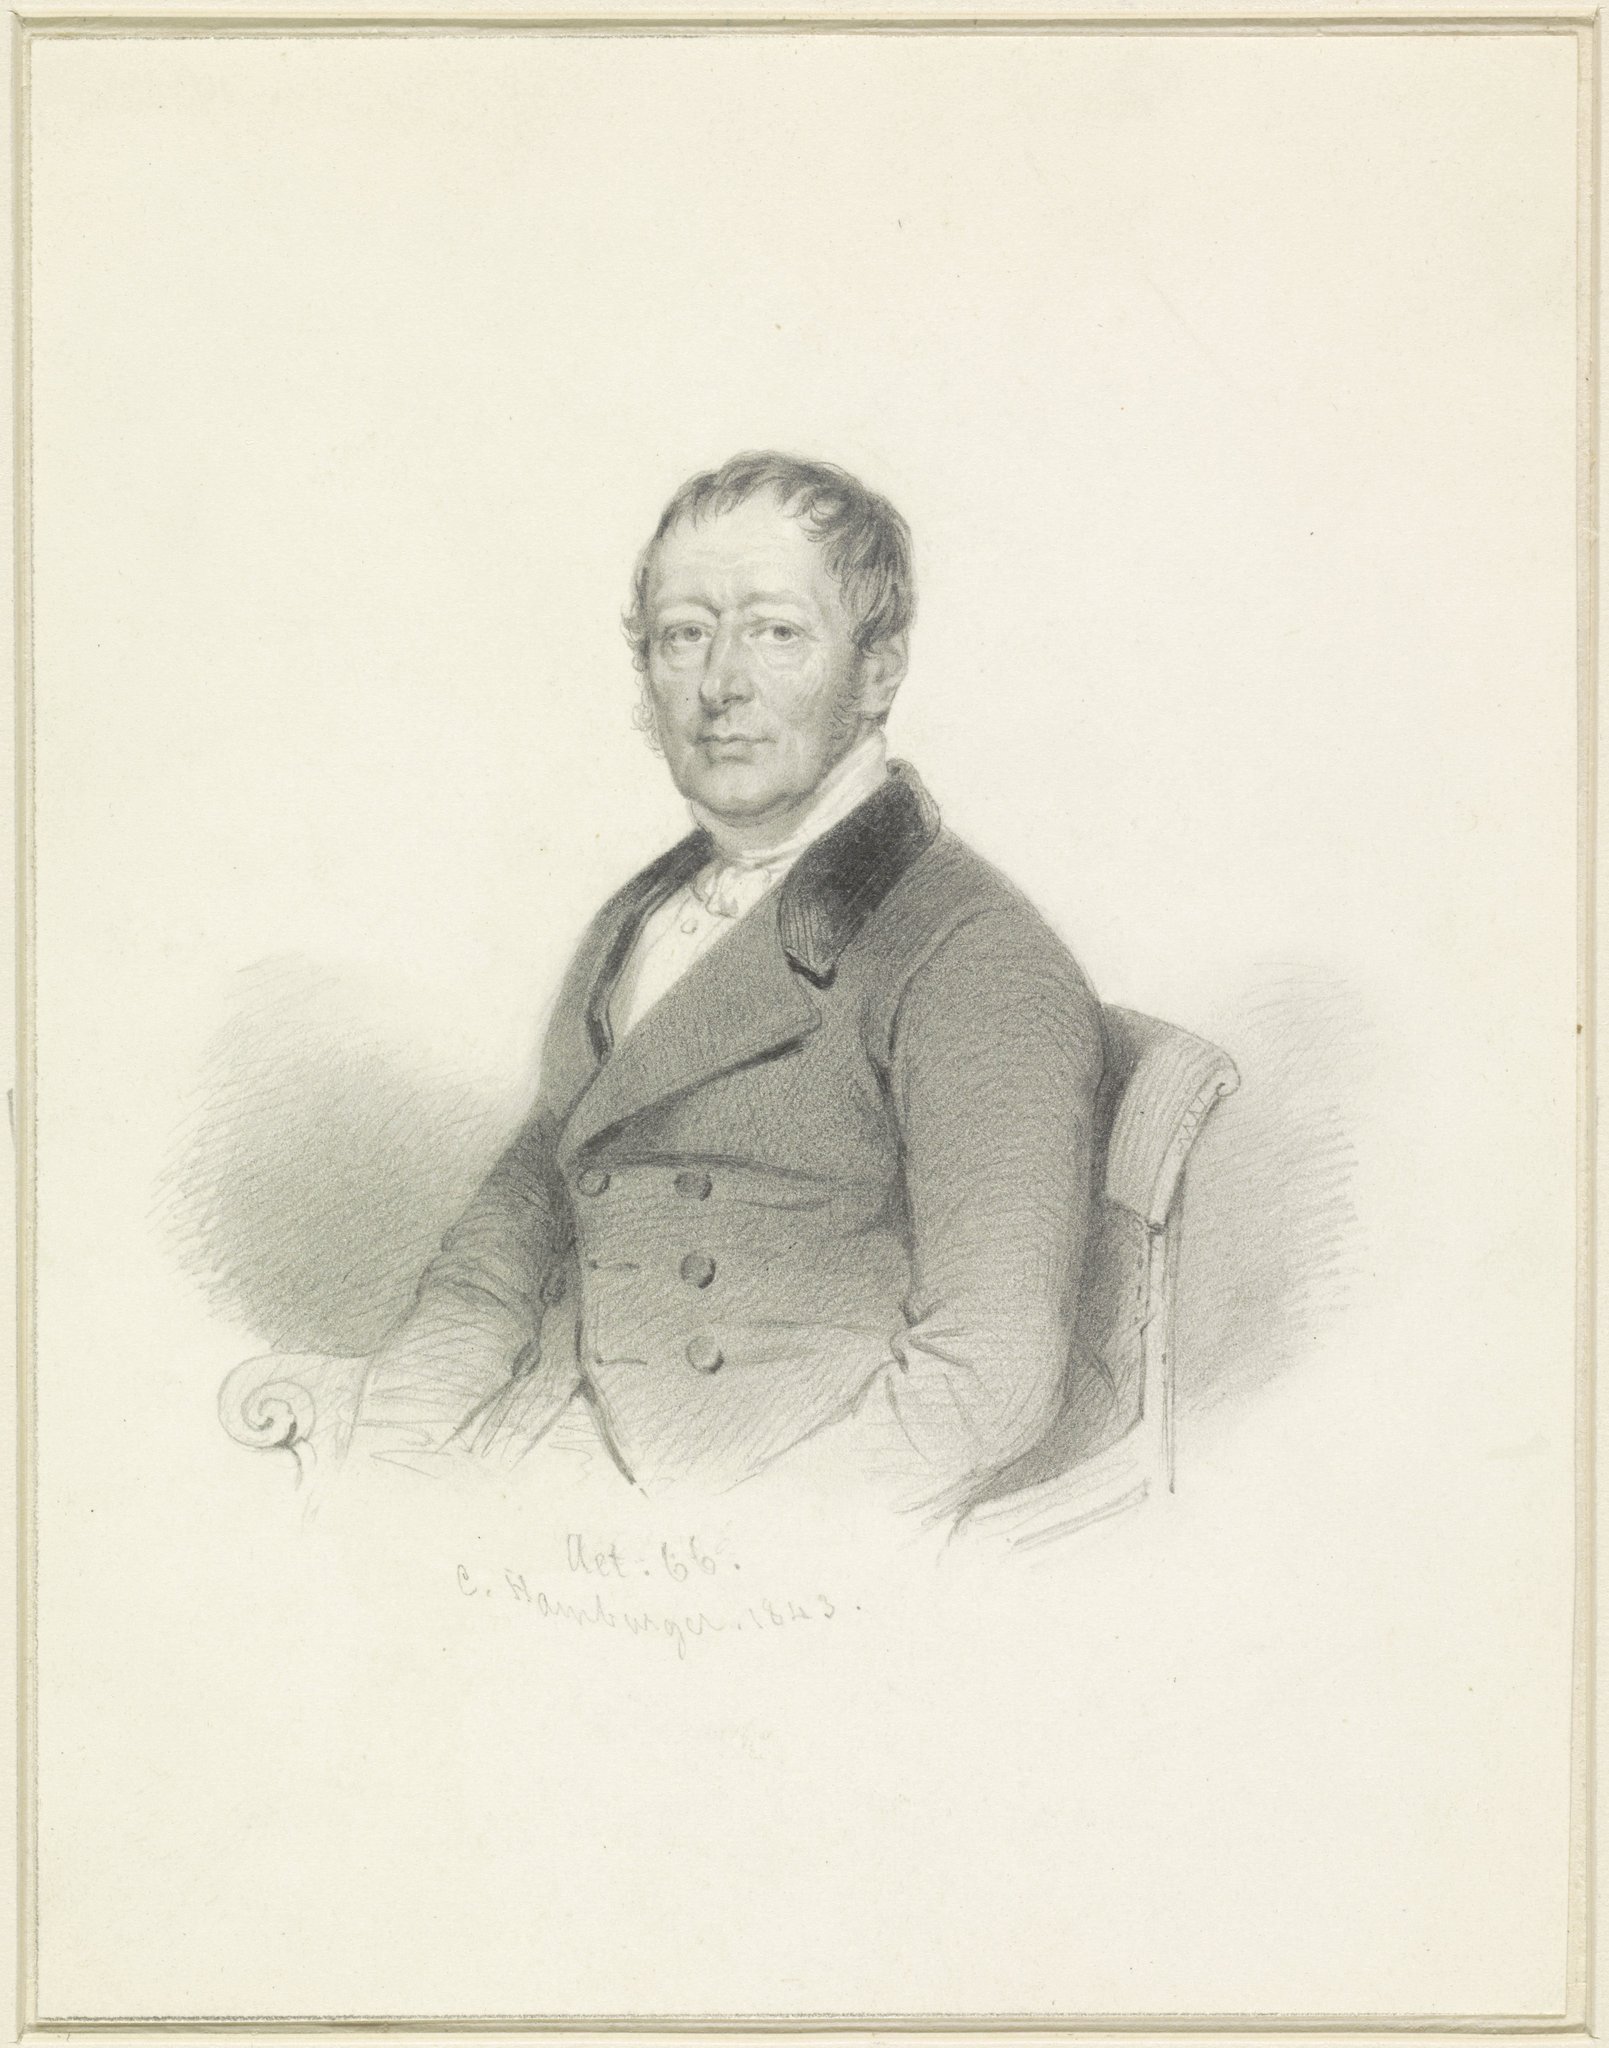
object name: drawing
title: Portret van Gerrit Lamberts, zittend in een stoel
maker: coenraad hamburger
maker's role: draughtsman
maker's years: 1809-1891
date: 1843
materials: paper, pencil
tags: amsterdam, print maker, draughtsman, bookseller, gerrit lamberts, historical persons, portrait, self-portrait of artist